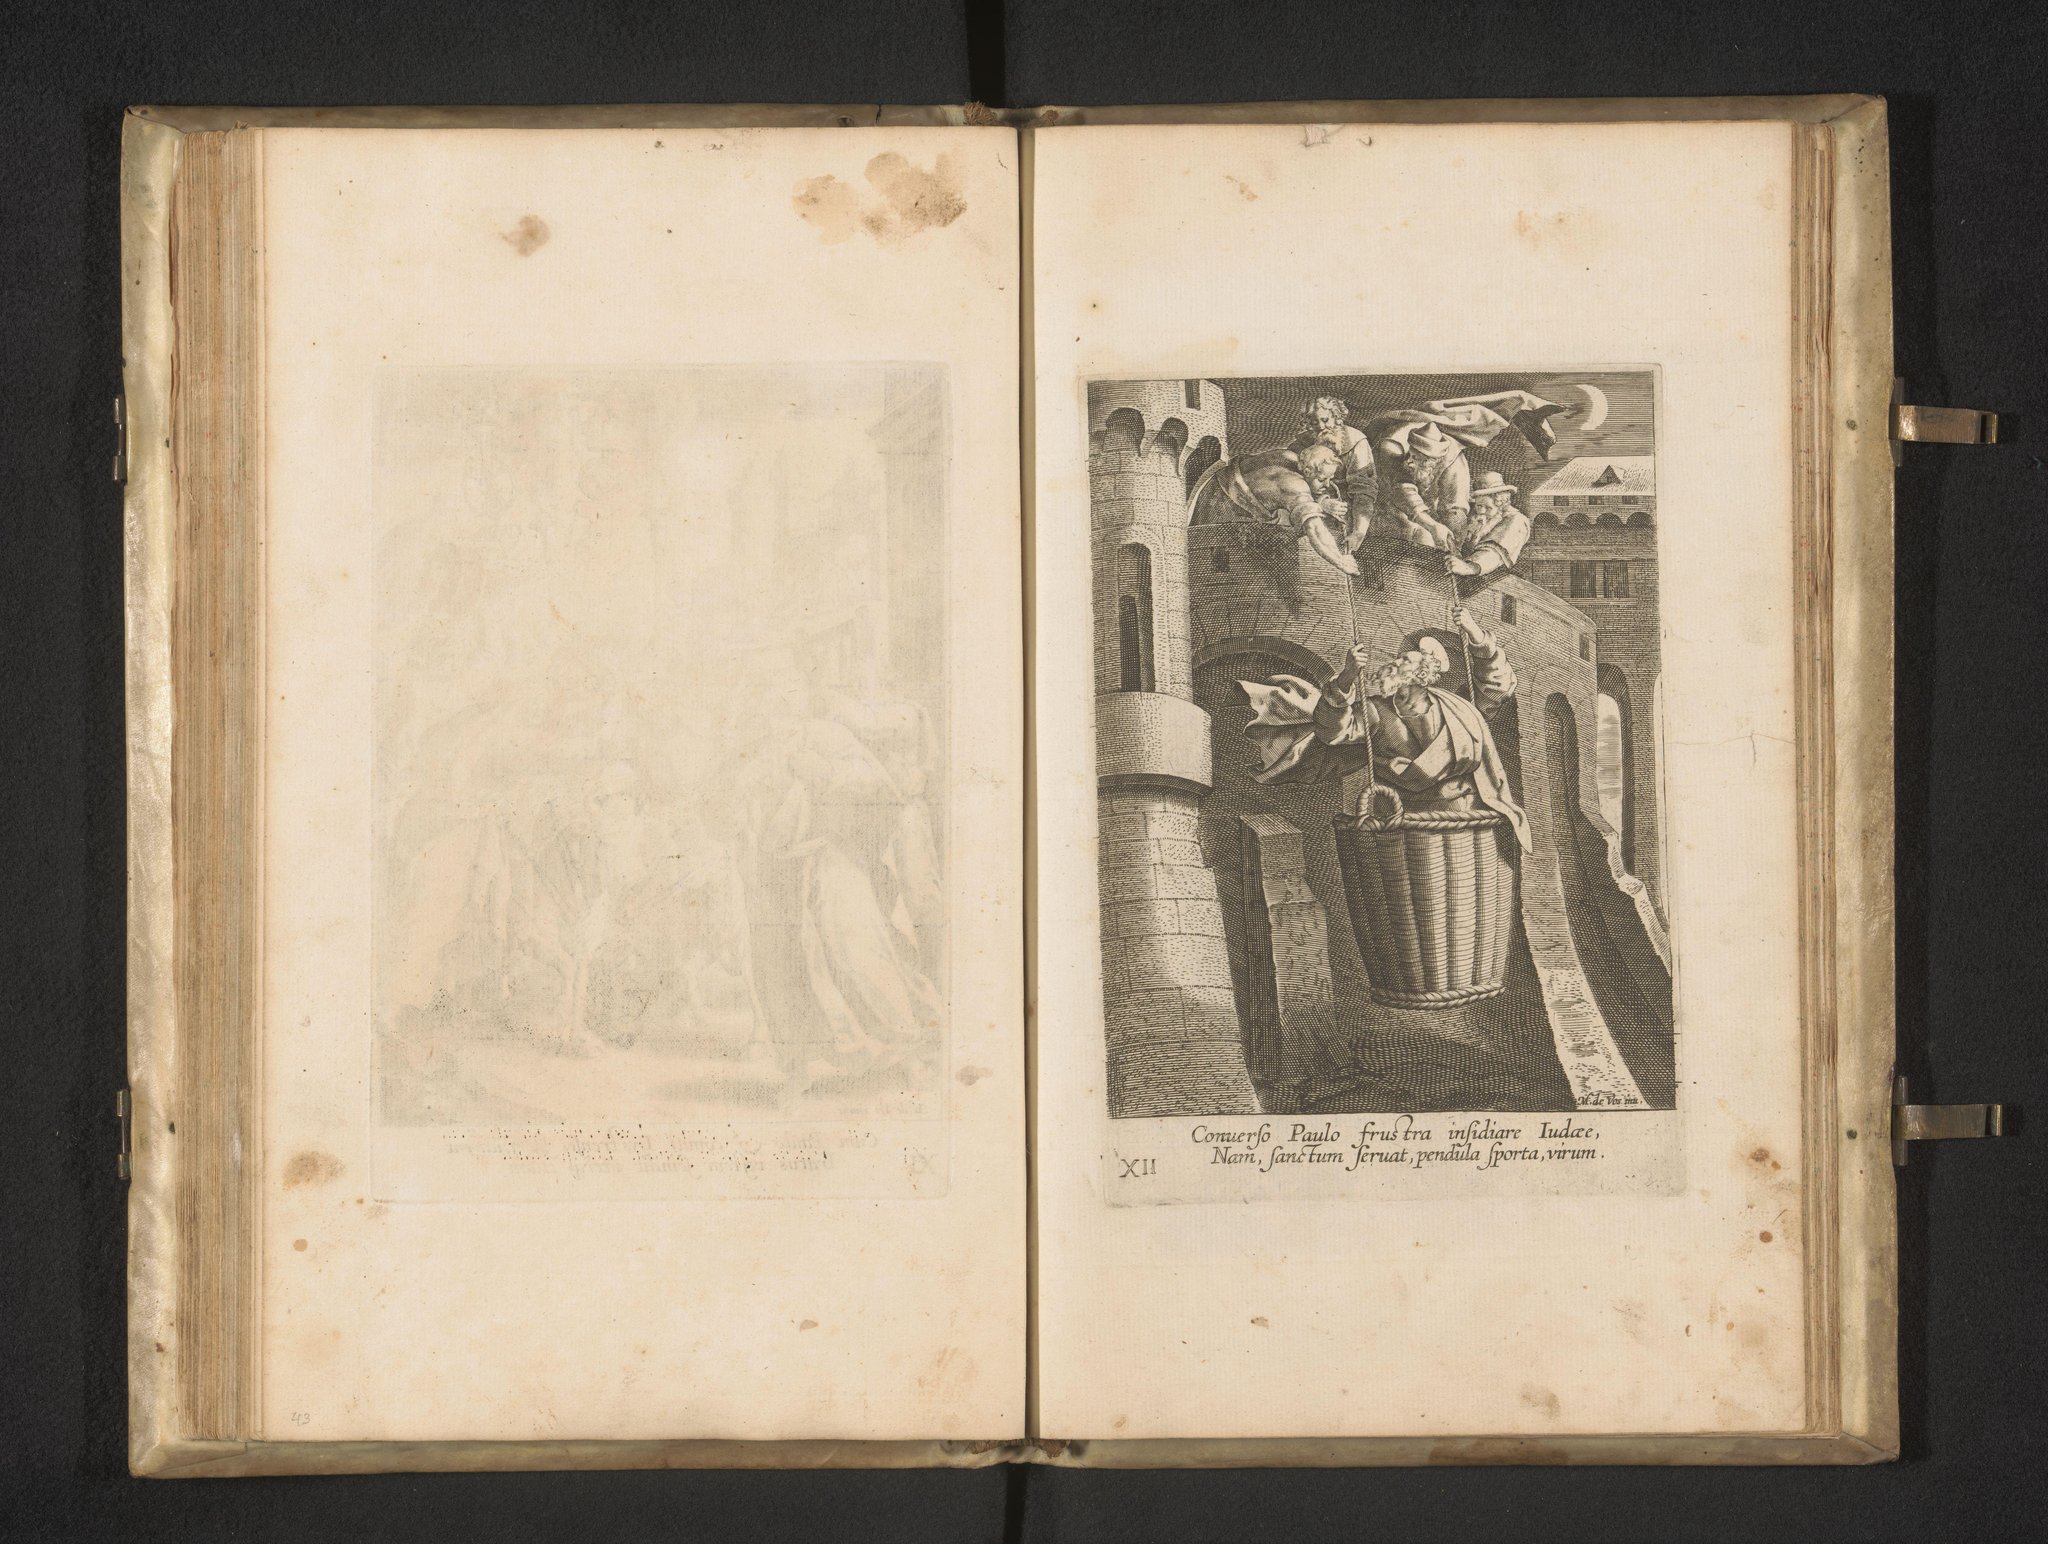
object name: print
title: Paulus vlucht uit Damascus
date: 1580-1585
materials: paper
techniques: engraving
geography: antwerp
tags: disciples let paul down the wall of the city in a basket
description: Paulus wordt door zijn leerlingen in een mand over de stadsmuur neergelaten om vervolging door de Joden te voorkomen. Linksonder genummerd: XII. Onderaan in de marge een tweeregelig onderschrift in het Latijn. Onderdeel van een serie van twaalf voorstellingen van de Handelingen van de apostelen. Onderdeel van een album met voornamelijk christelijke voorstellingen.